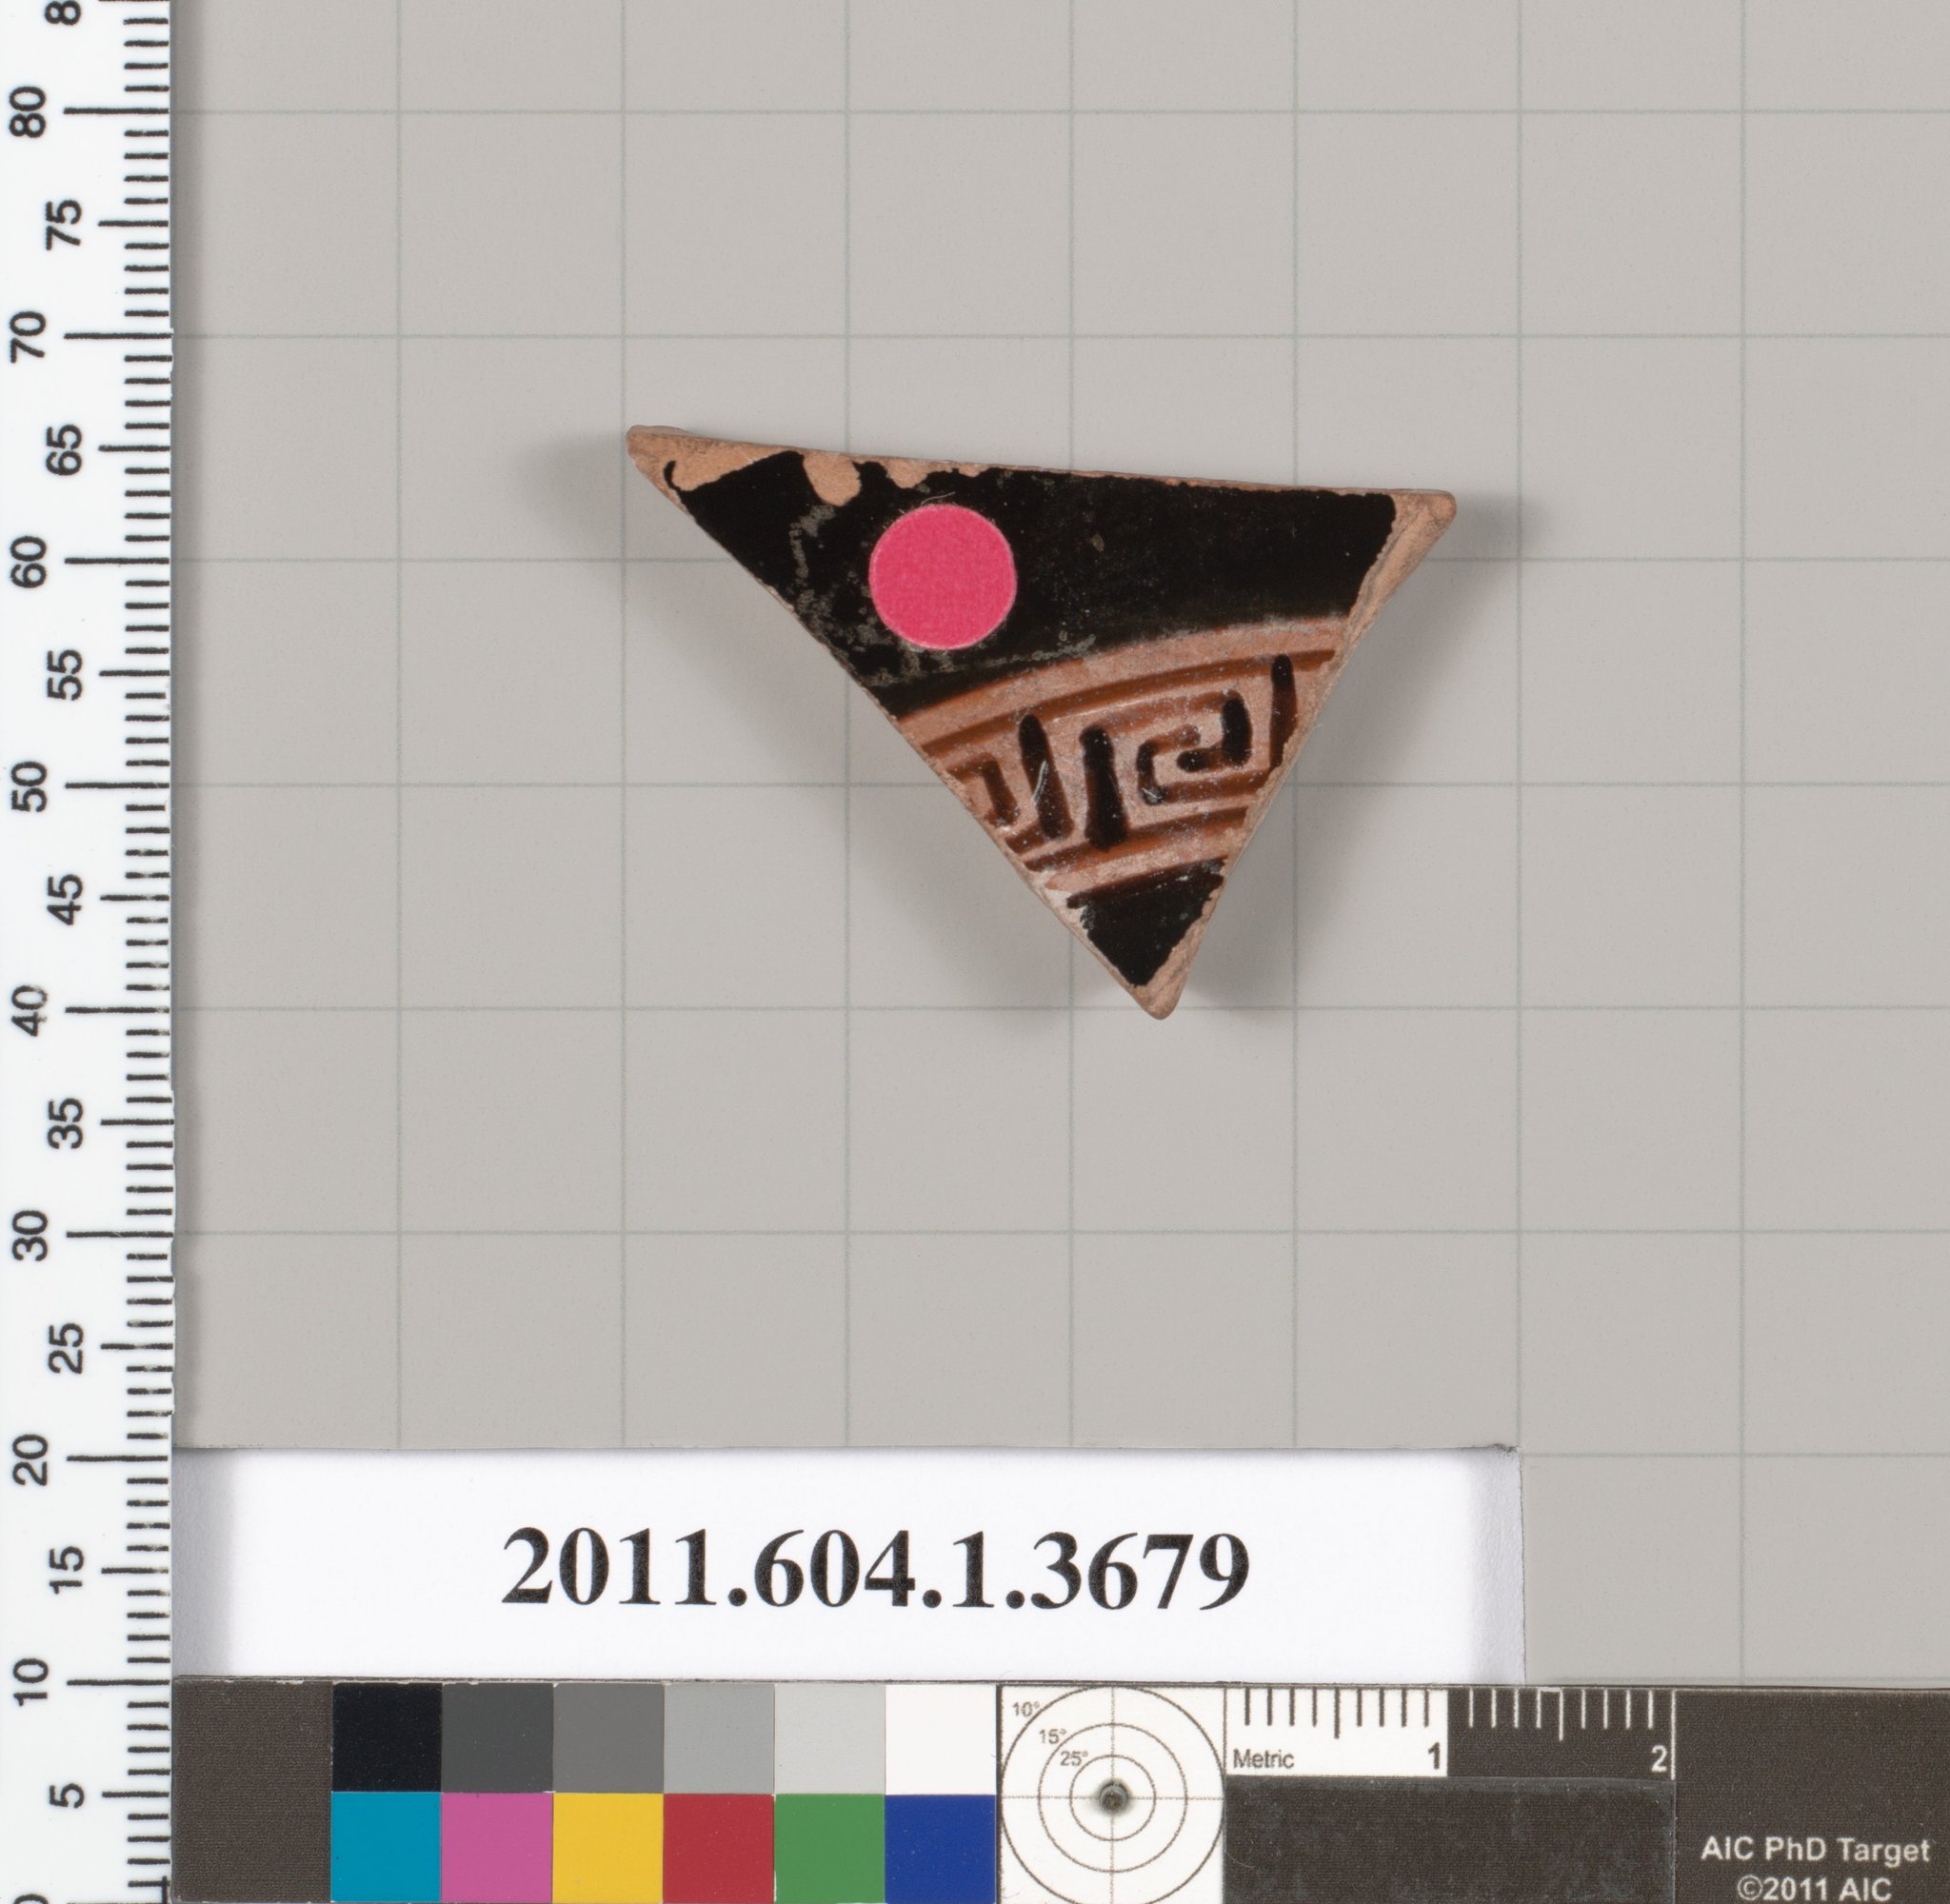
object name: kylix fragment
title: Terracotta fragment of a kylix (drinking cup)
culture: greek, attic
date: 475-451 BCE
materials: terracotta